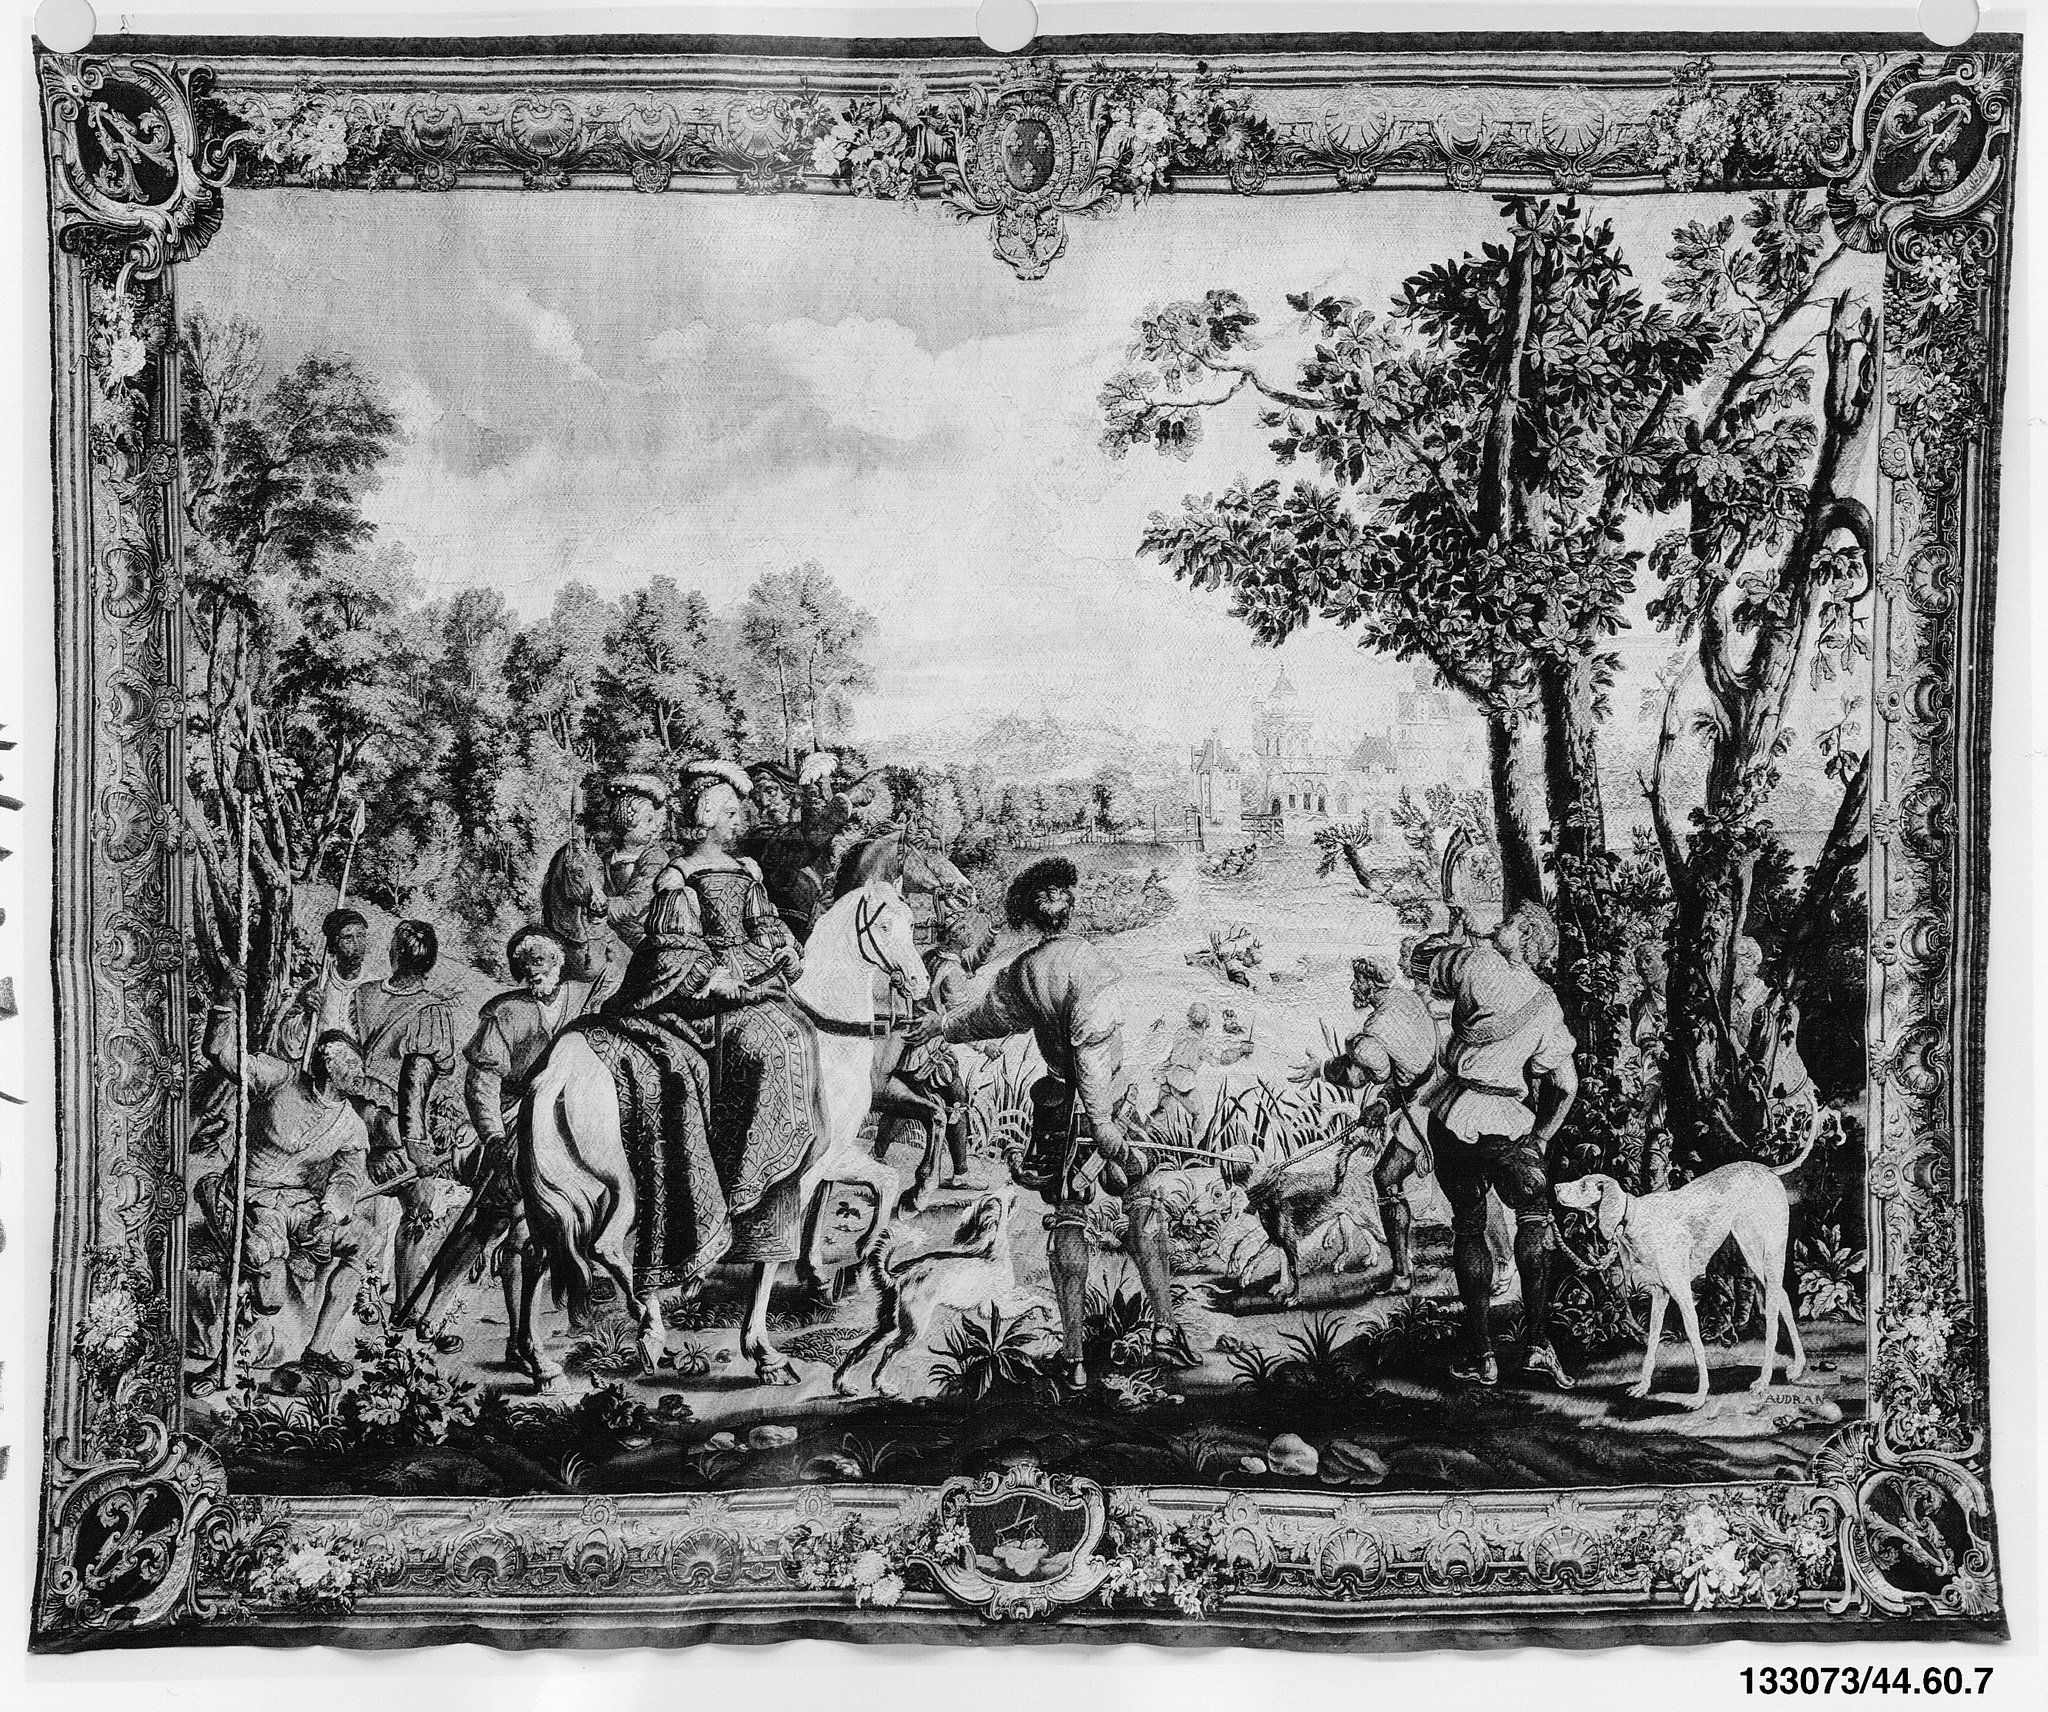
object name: tapestry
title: September from a set of The Months of Lucas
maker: master of the months of lucas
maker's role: designer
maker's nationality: netherlandish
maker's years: 1535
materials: silk, wool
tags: men,women,dogs